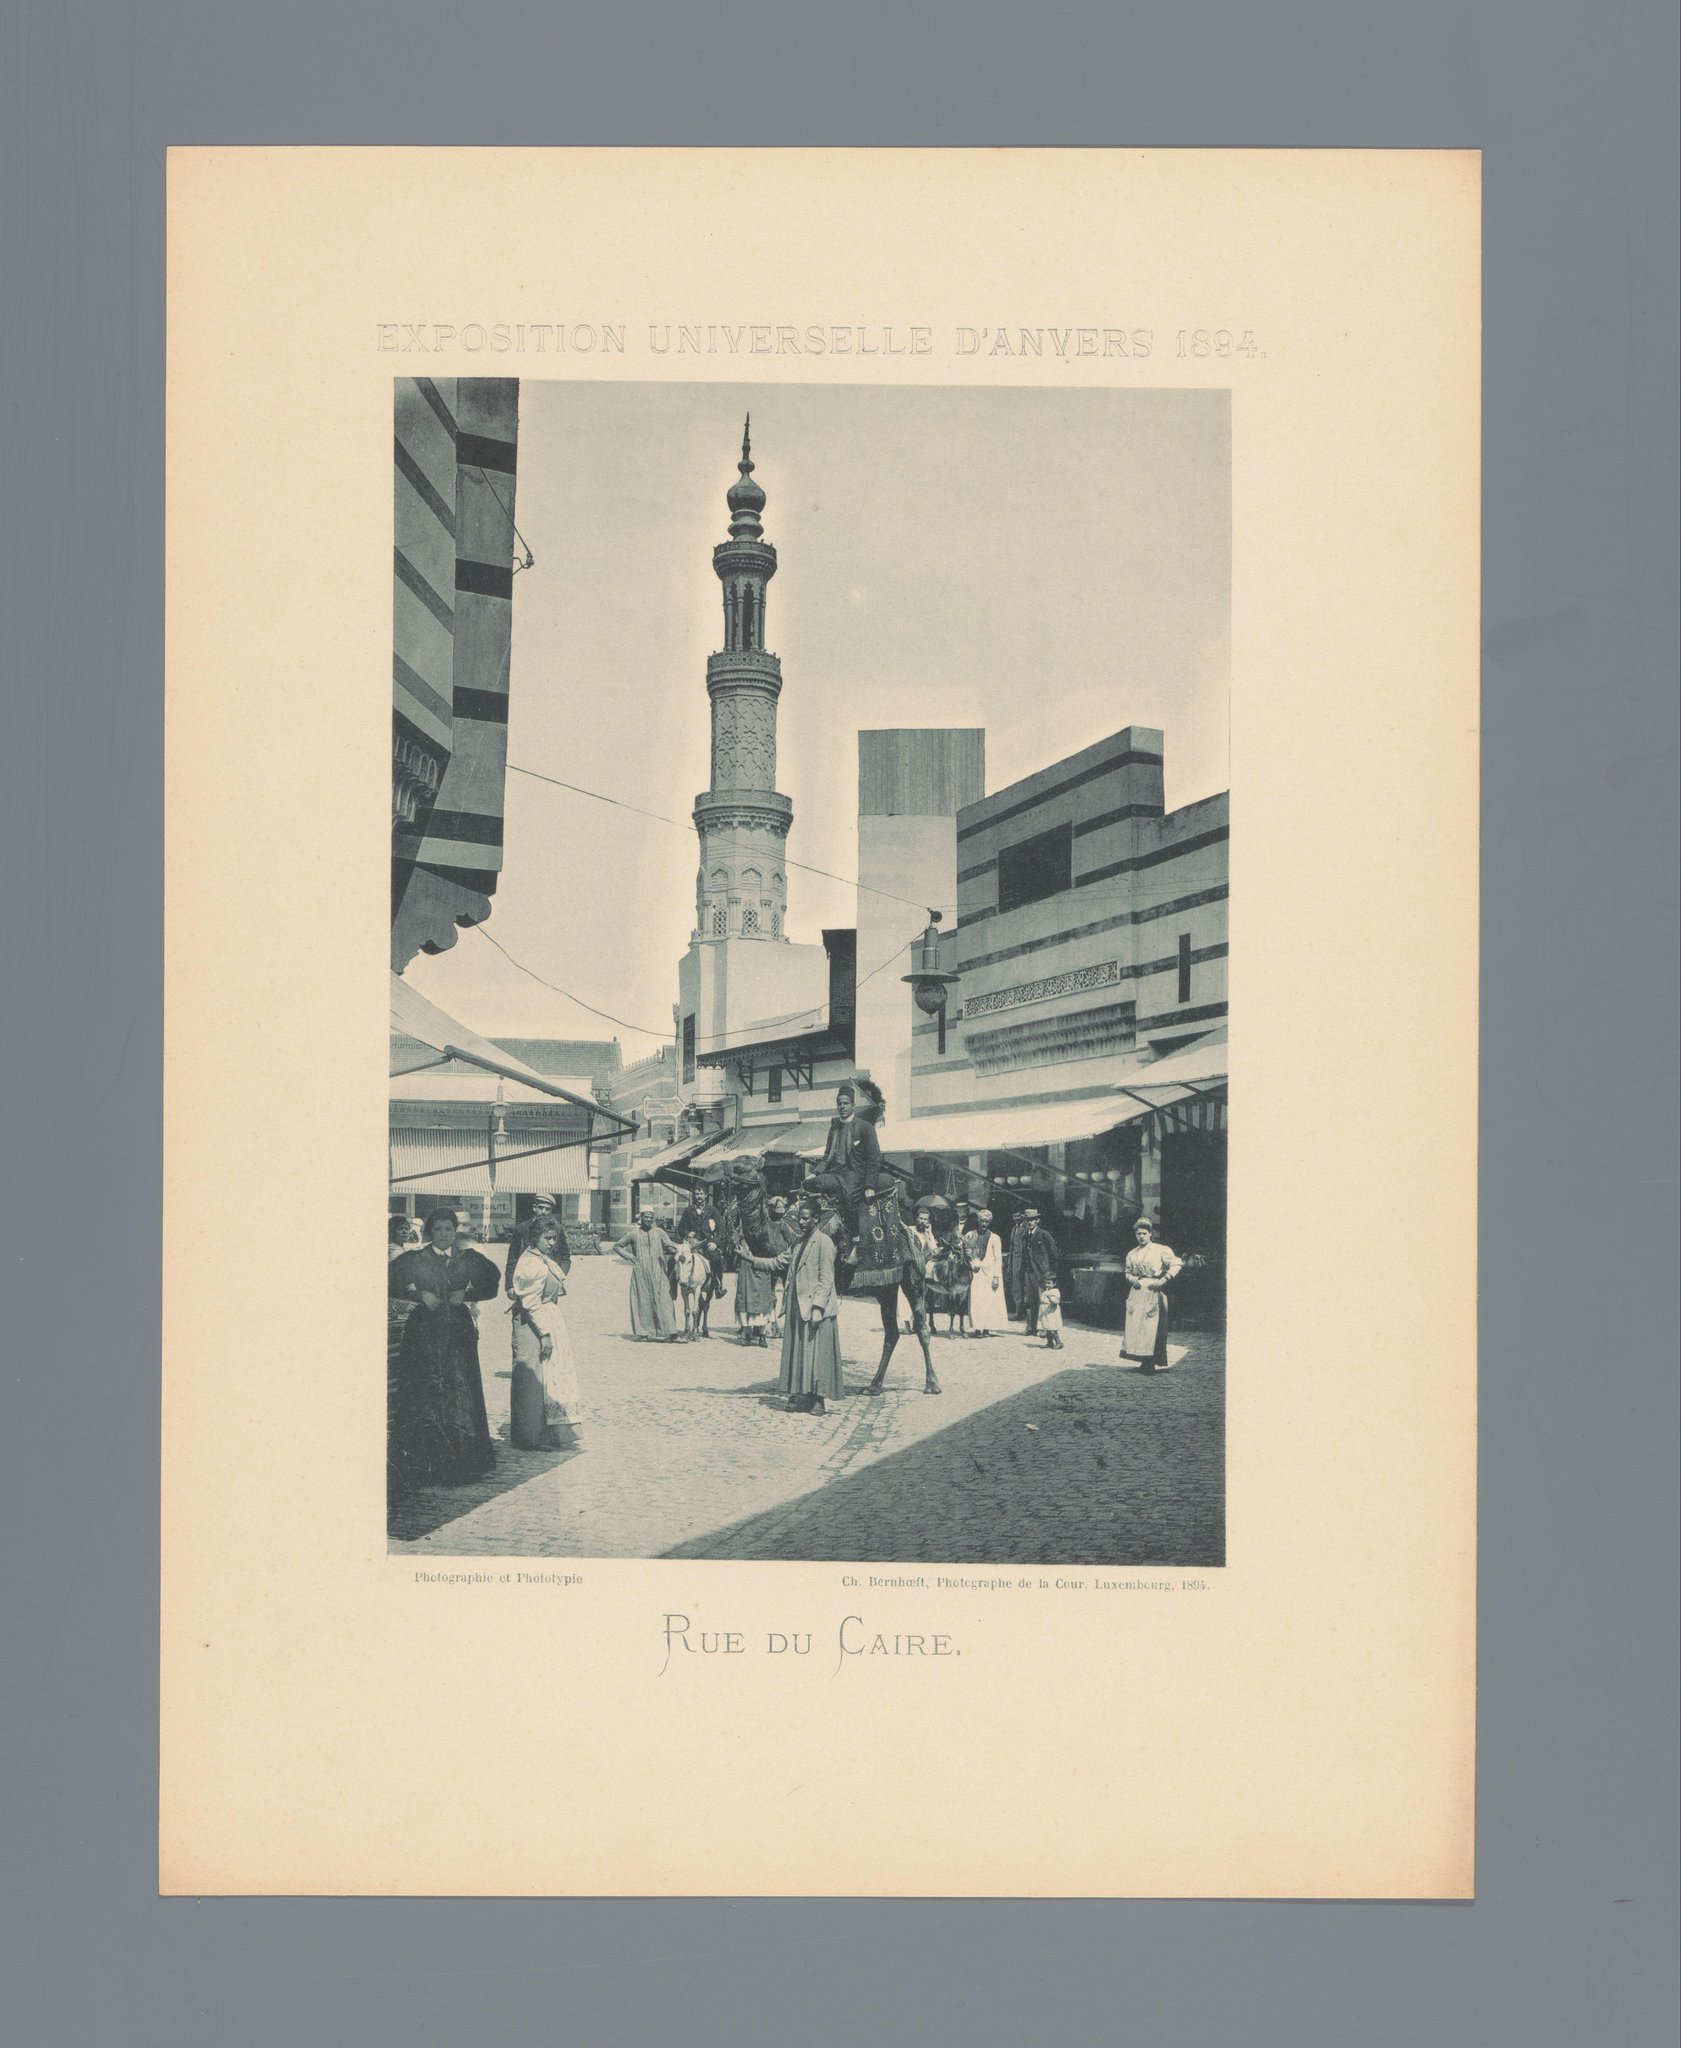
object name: photomechanical print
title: Rue de Caire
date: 1894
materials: paper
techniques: photograph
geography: luxembourg city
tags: asiatic races and peoples (egyptians), hoofed animals: dromedary, world fair, world exhibition, historical persons, antwerp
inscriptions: inscription: ‘Exposition Universelle D'Anvers 1894’